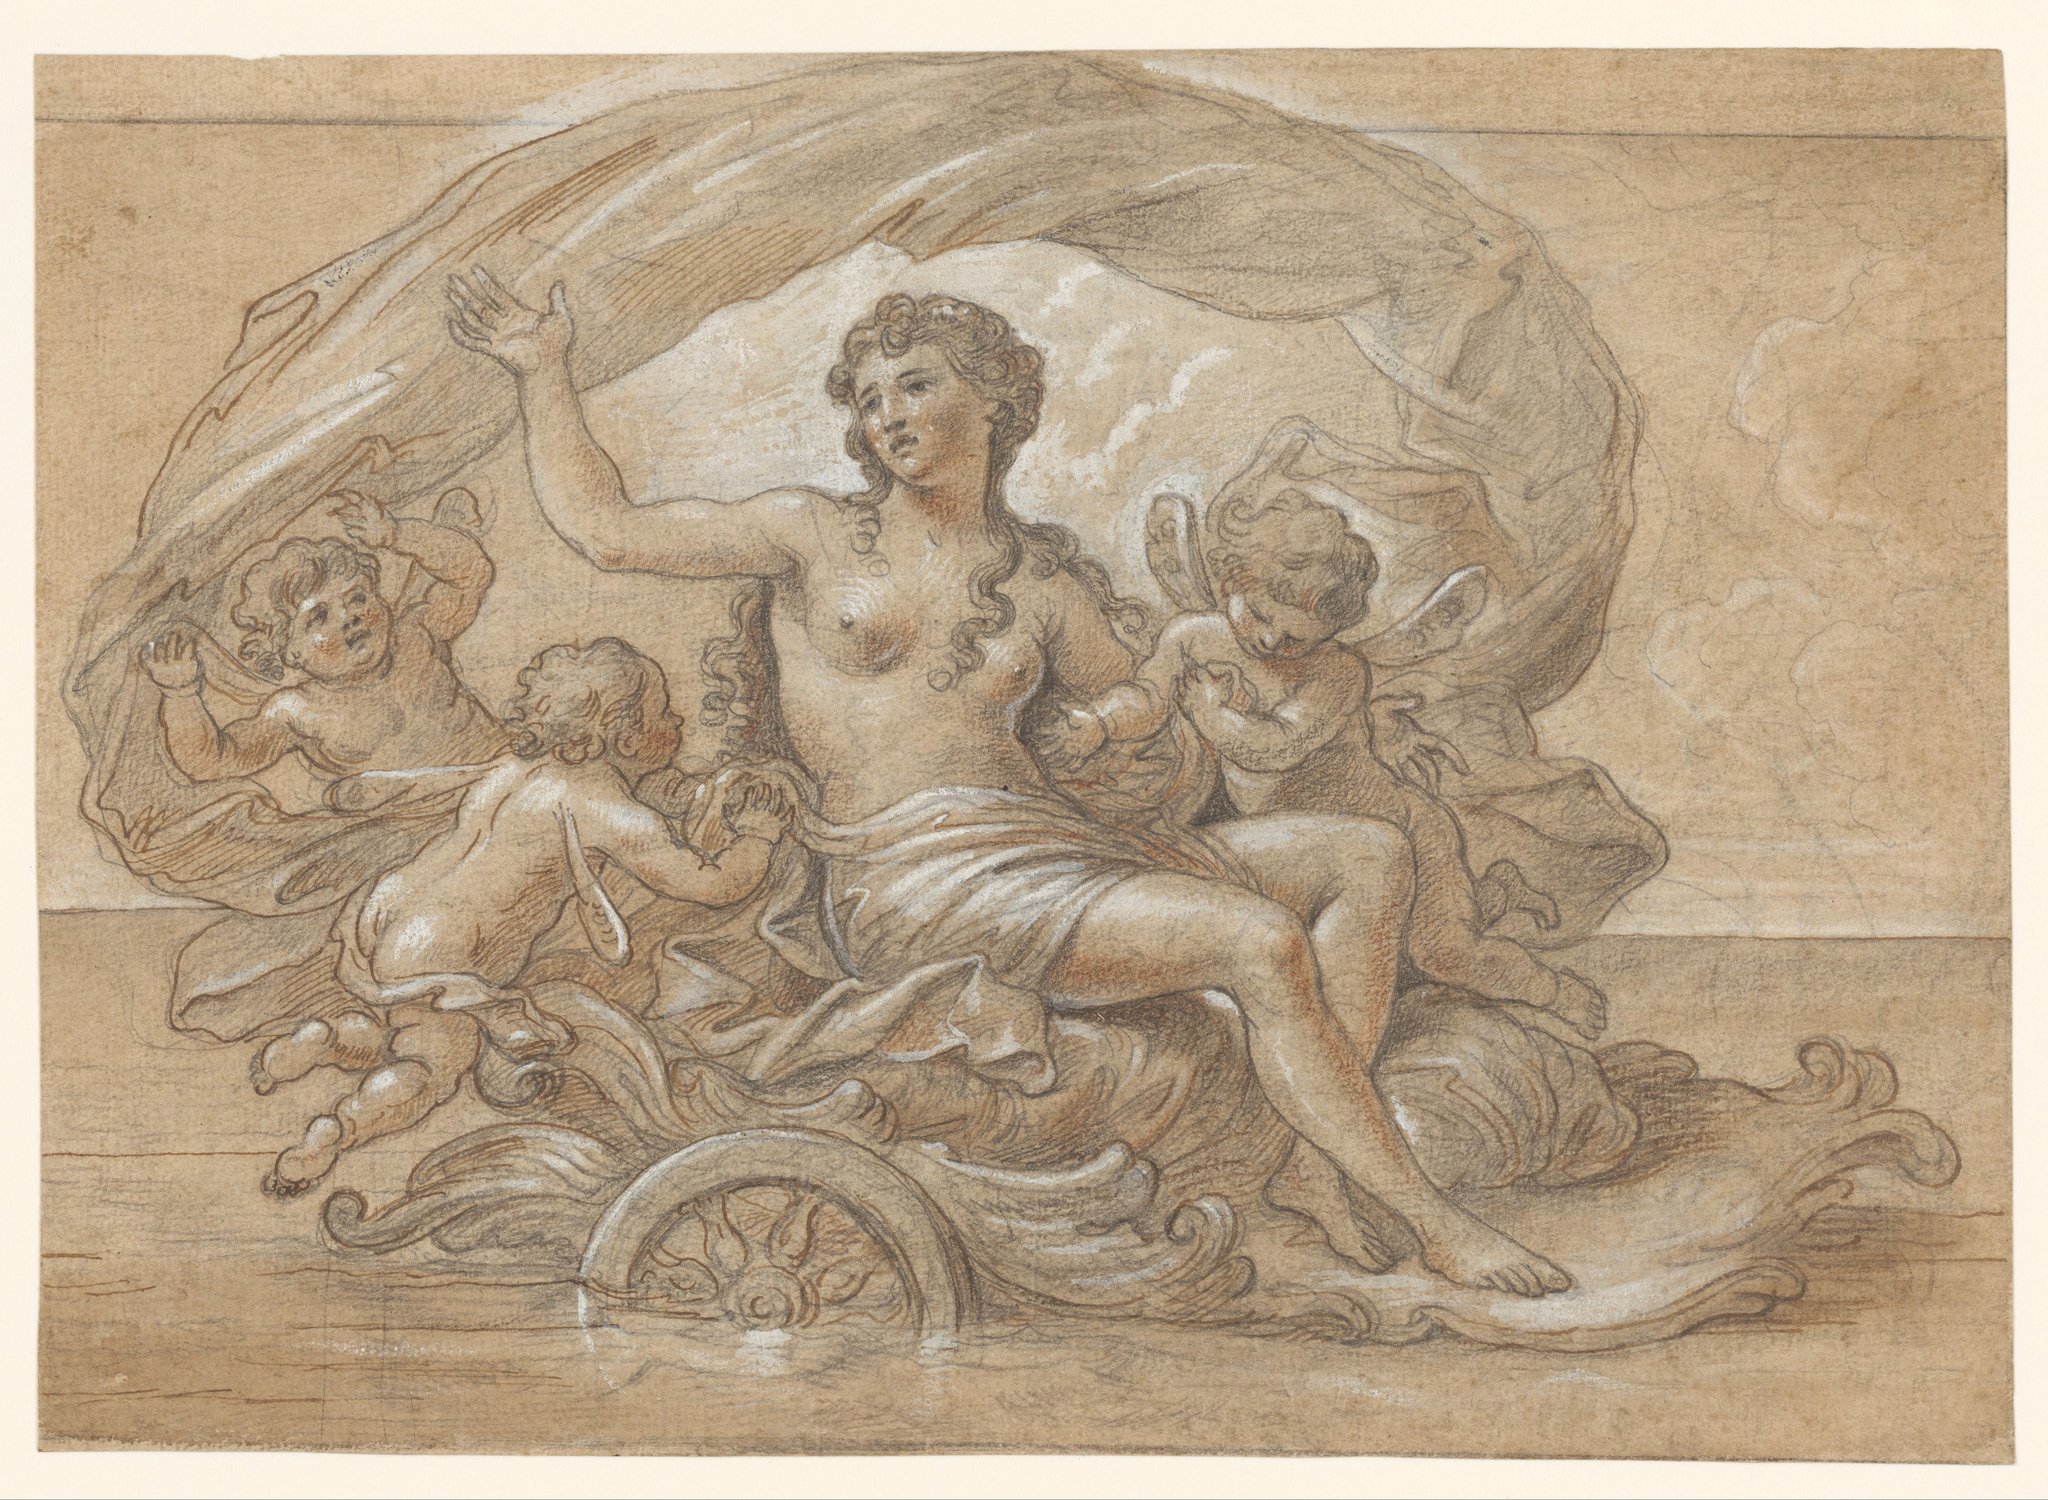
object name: drawing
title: Galathea op haar zeewagen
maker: antoine coypel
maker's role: draughtsman, print maker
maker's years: 1661-1722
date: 1671-1722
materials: chalk, paper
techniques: brush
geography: france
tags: triumph of galatea